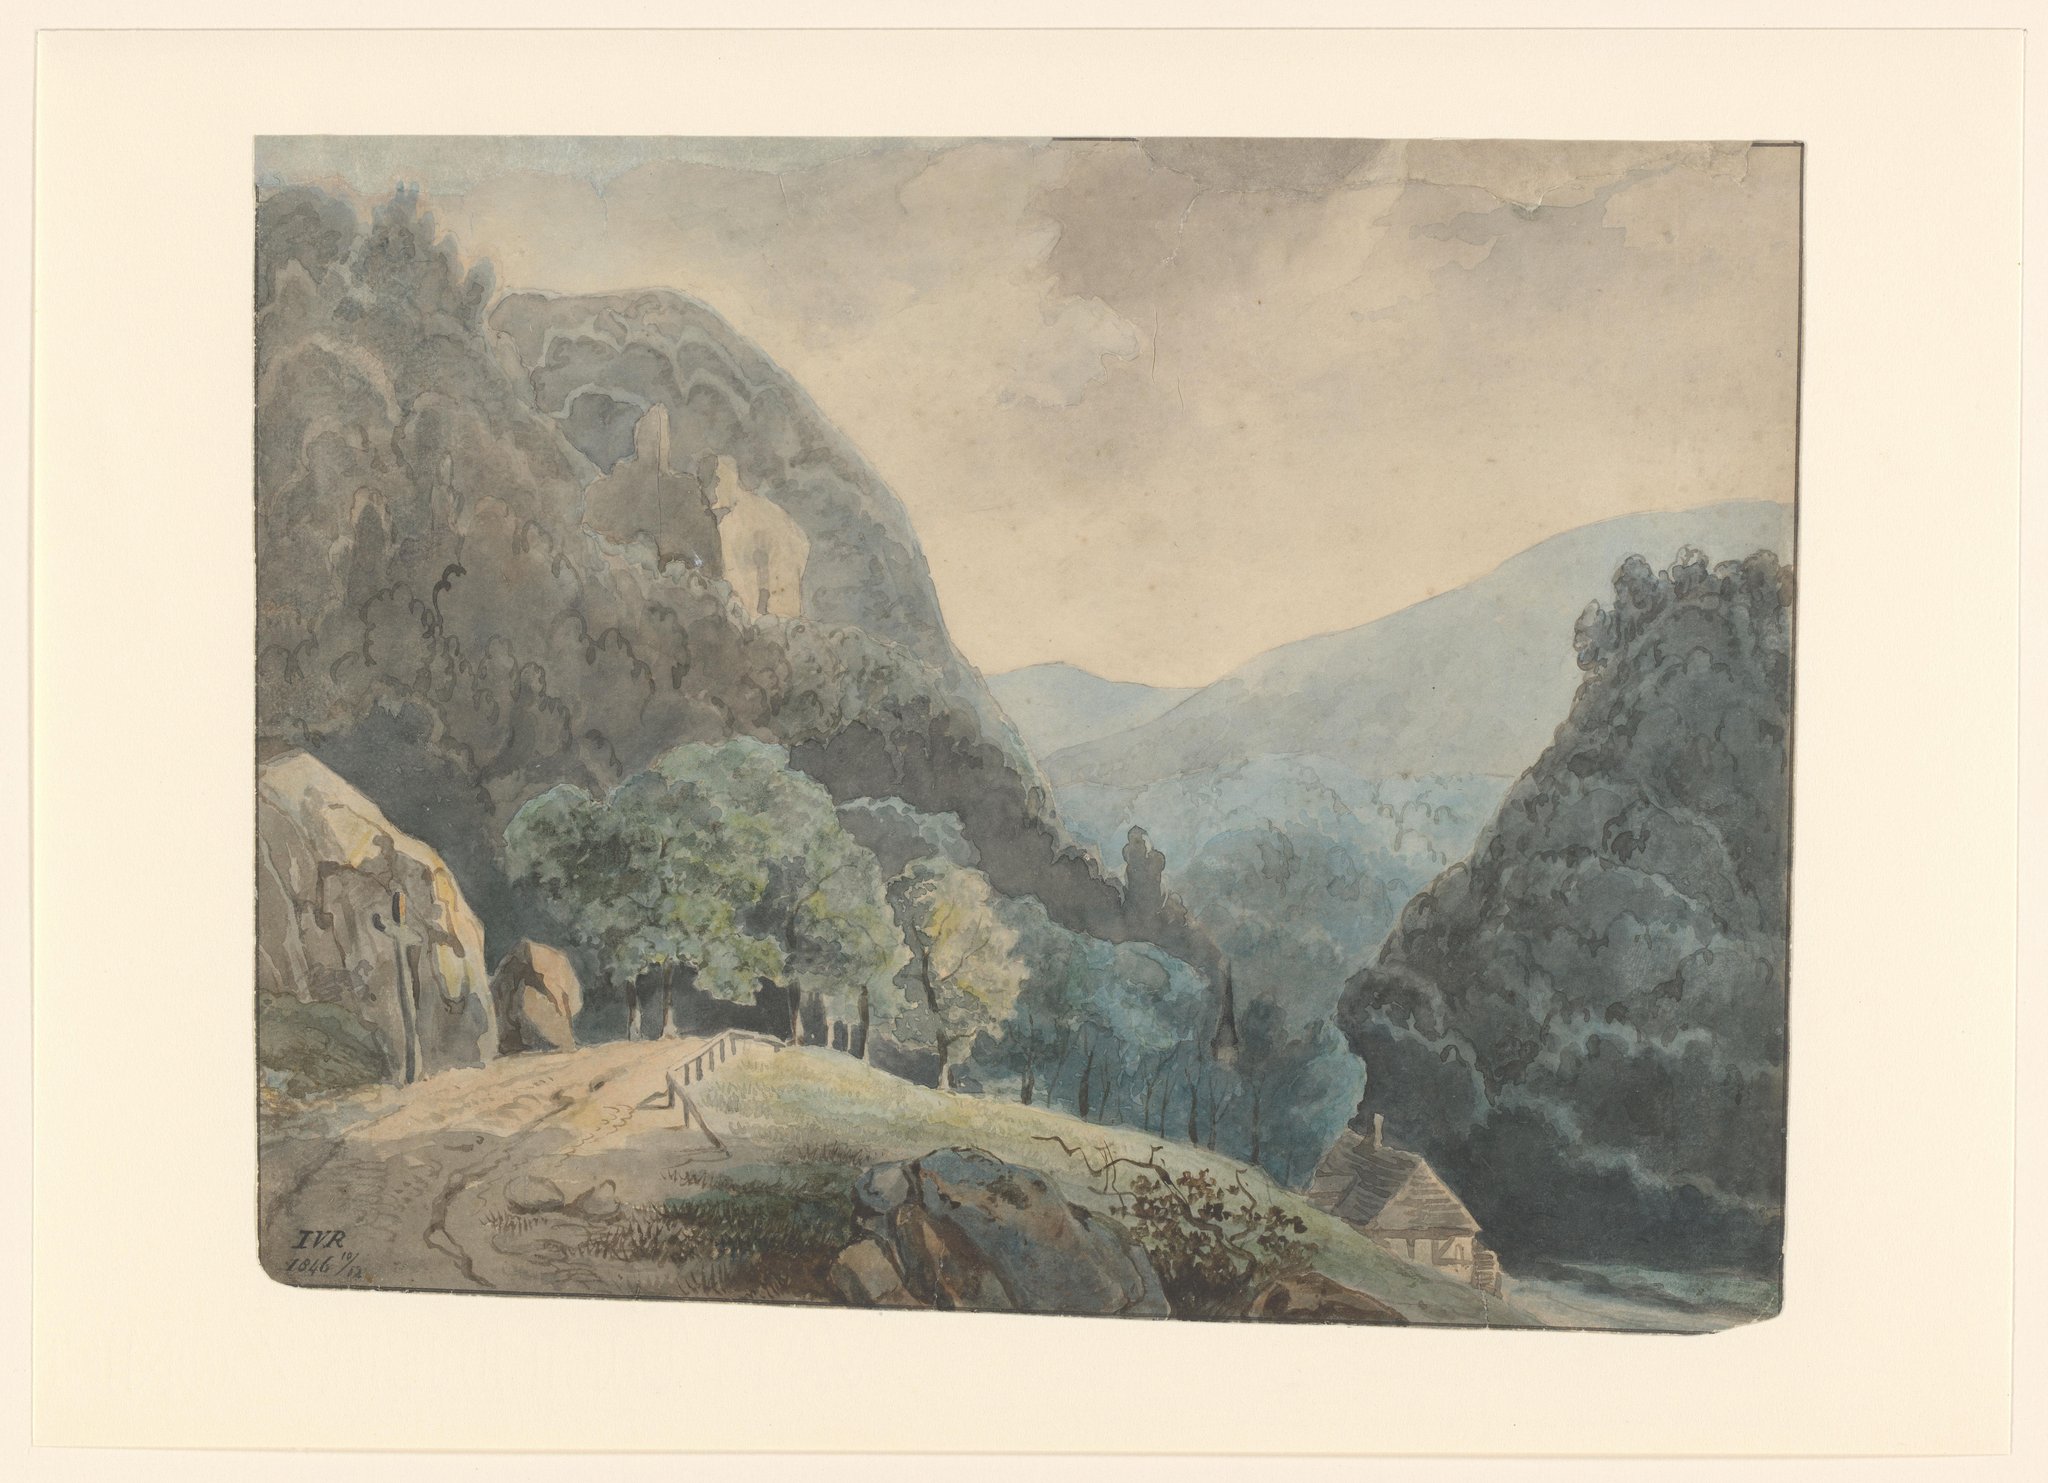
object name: watercolor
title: Berglandschap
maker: monogrammist ivr (19e eeuw)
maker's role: draughtsman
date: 1846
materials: chalk, paper, watercolor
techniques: brush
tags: mountains